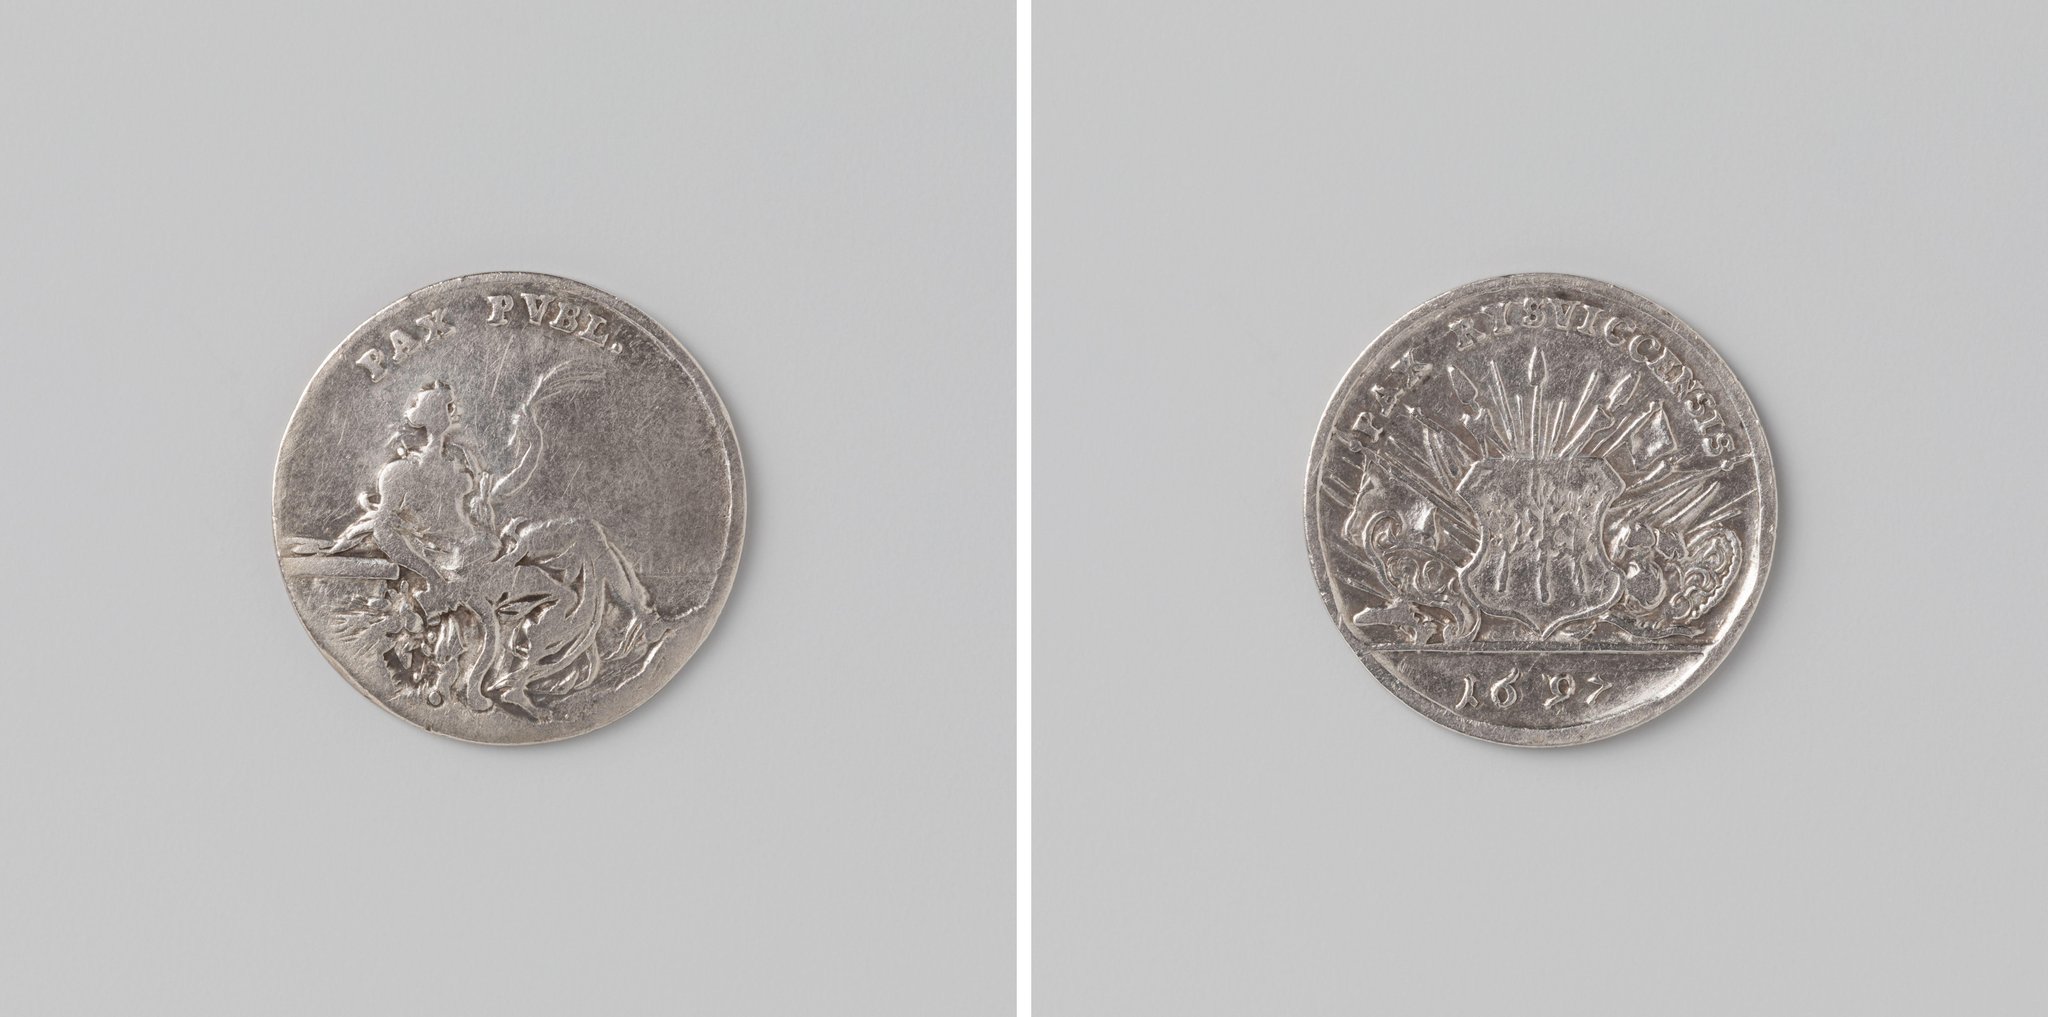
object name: strooipenning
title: Vrede van Rijswijk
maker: Anonymous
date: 1697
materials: silver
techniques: striking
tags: rijswijk, vrede van rijswijk (1697)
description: Zilveren penning. Voorzijde: Vrede met palmtak en hoorn van overvloed zittend tegen altaar binnen omschrift. Keerzijde: trophee van wapens en vlaggen met daarvoor wapenschild binnen omschrift; afsnede: jaartal